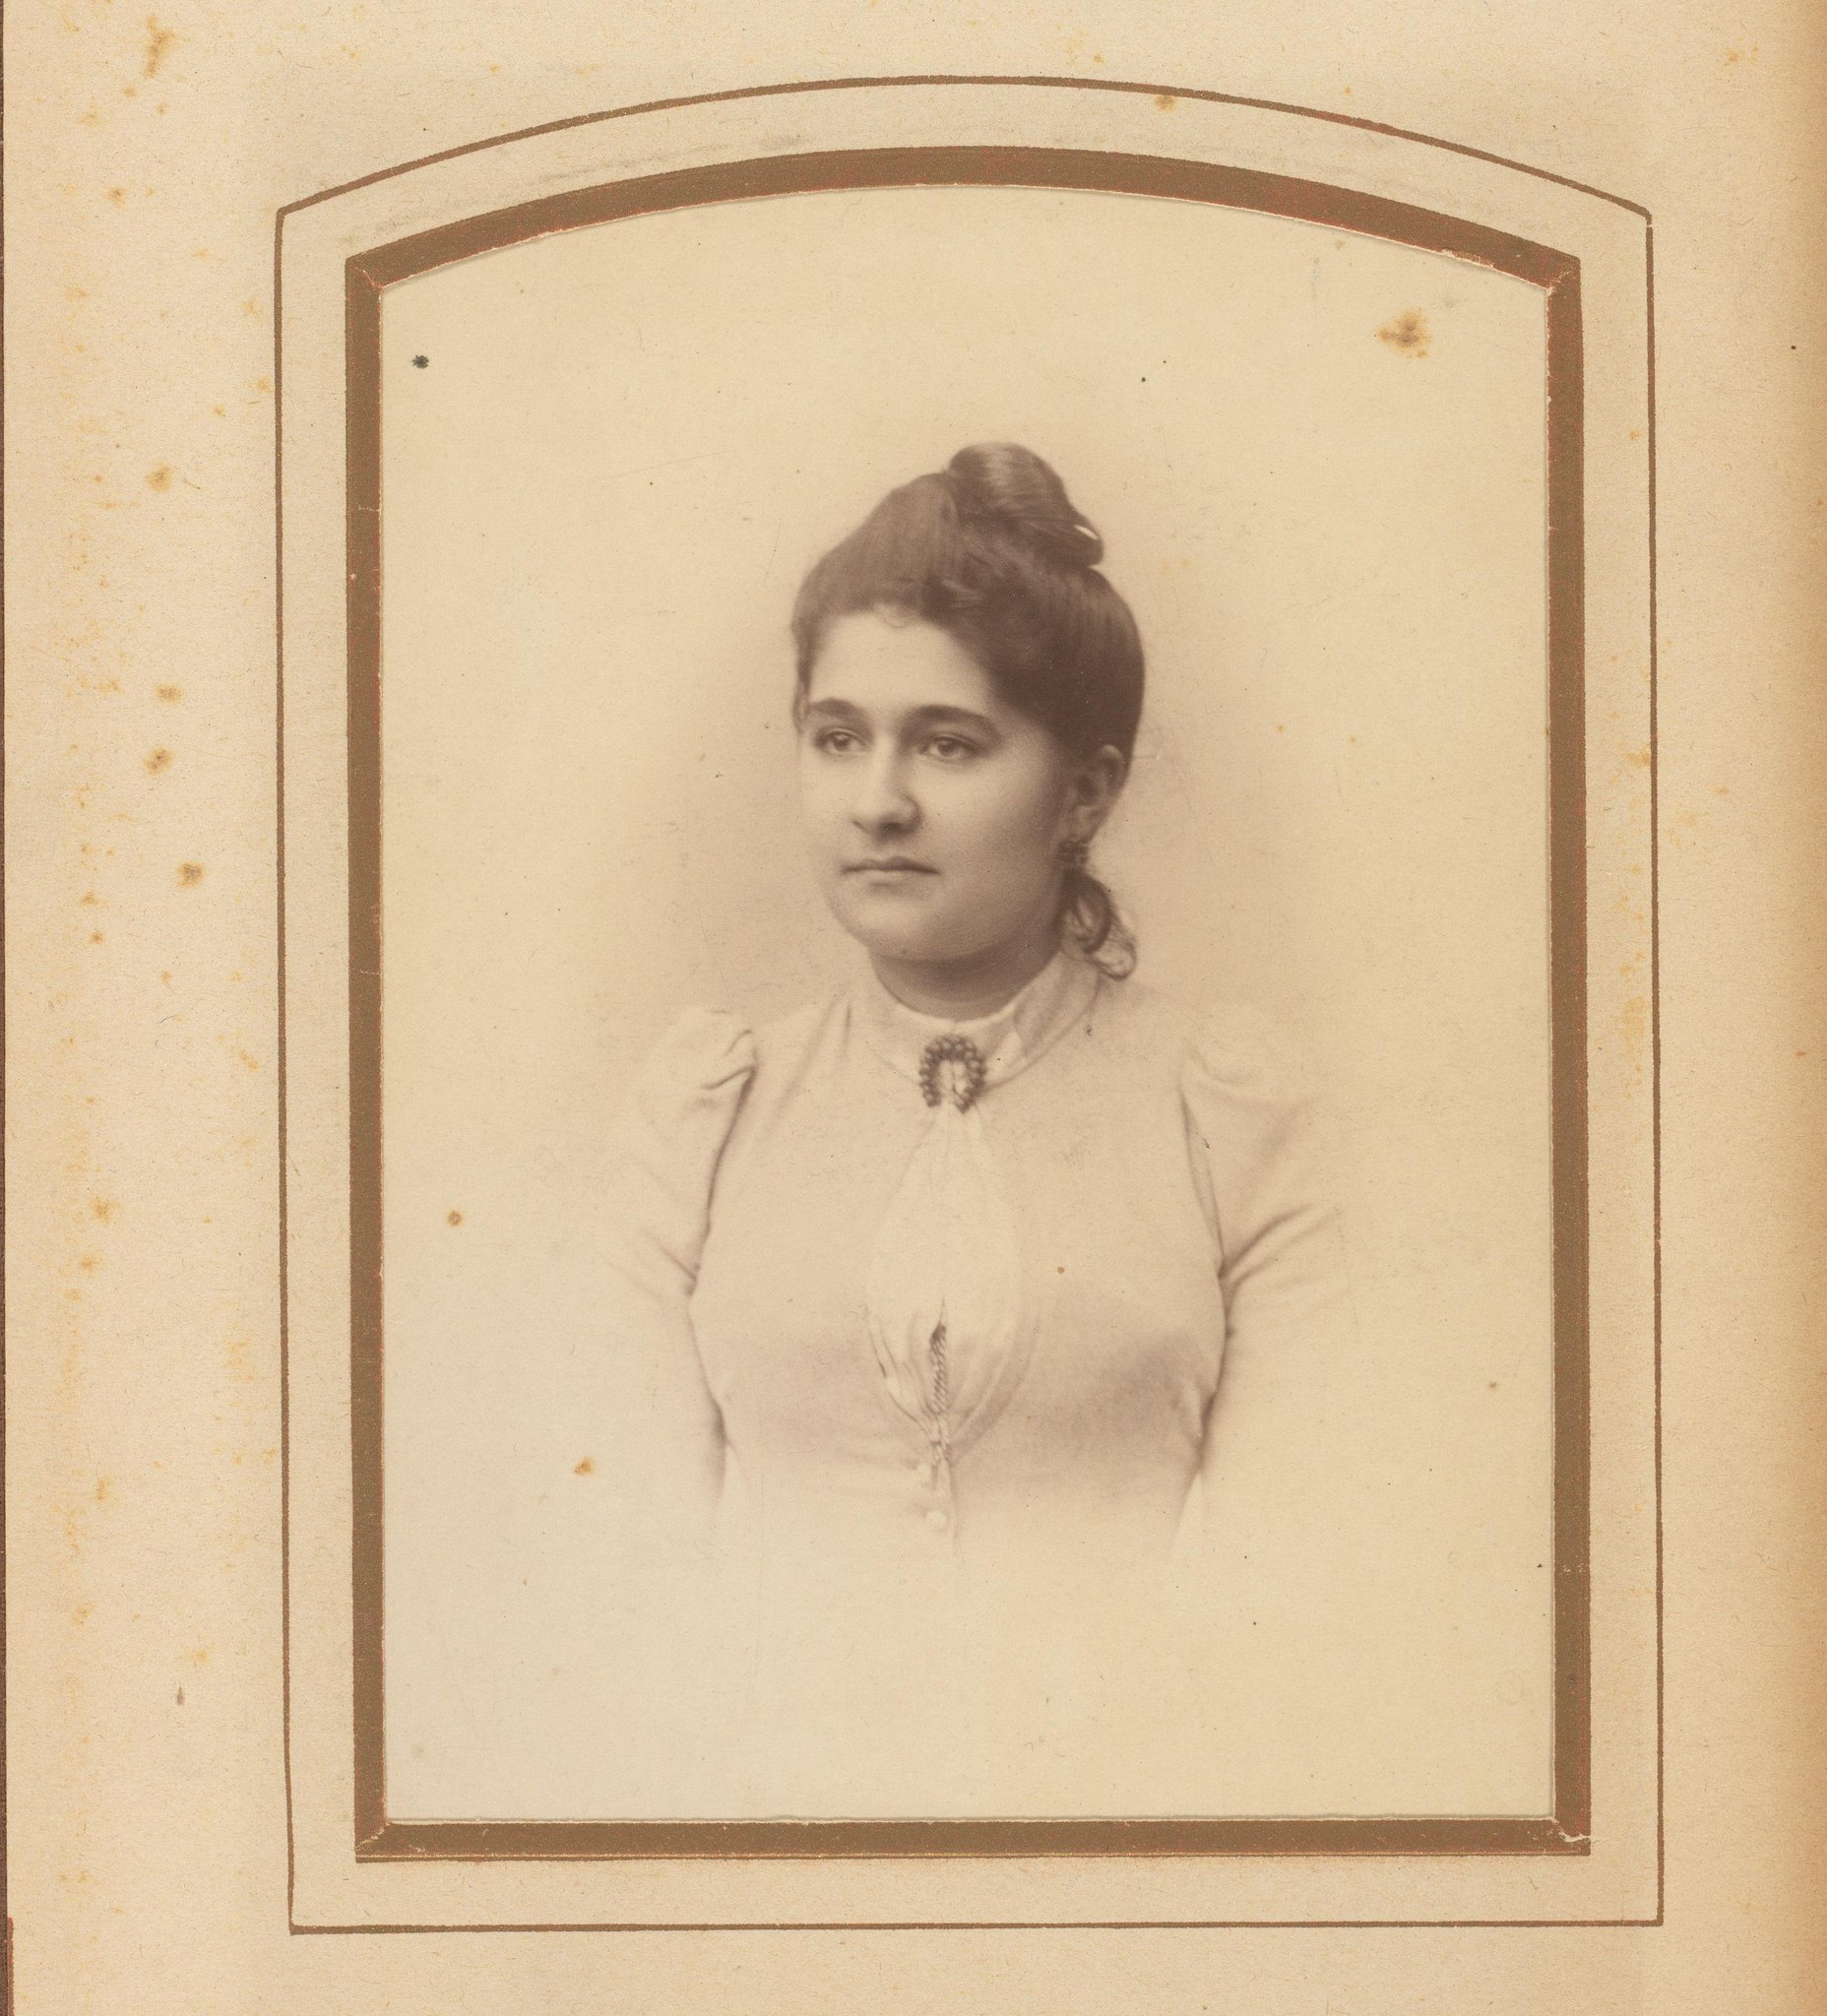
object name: cabinet photograph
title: Portret van een vrouw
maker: hendrik jonker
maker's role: fotograaf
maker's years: 1846-1932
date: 1882-1914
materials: cardboard, photographic support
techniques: albumen print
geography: leiden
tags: historical persons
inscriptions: annotation: ‘AV’, inscription: ‘H. Jonker/ Photograaf/ Leiden/ Apothekersdijk No.7’